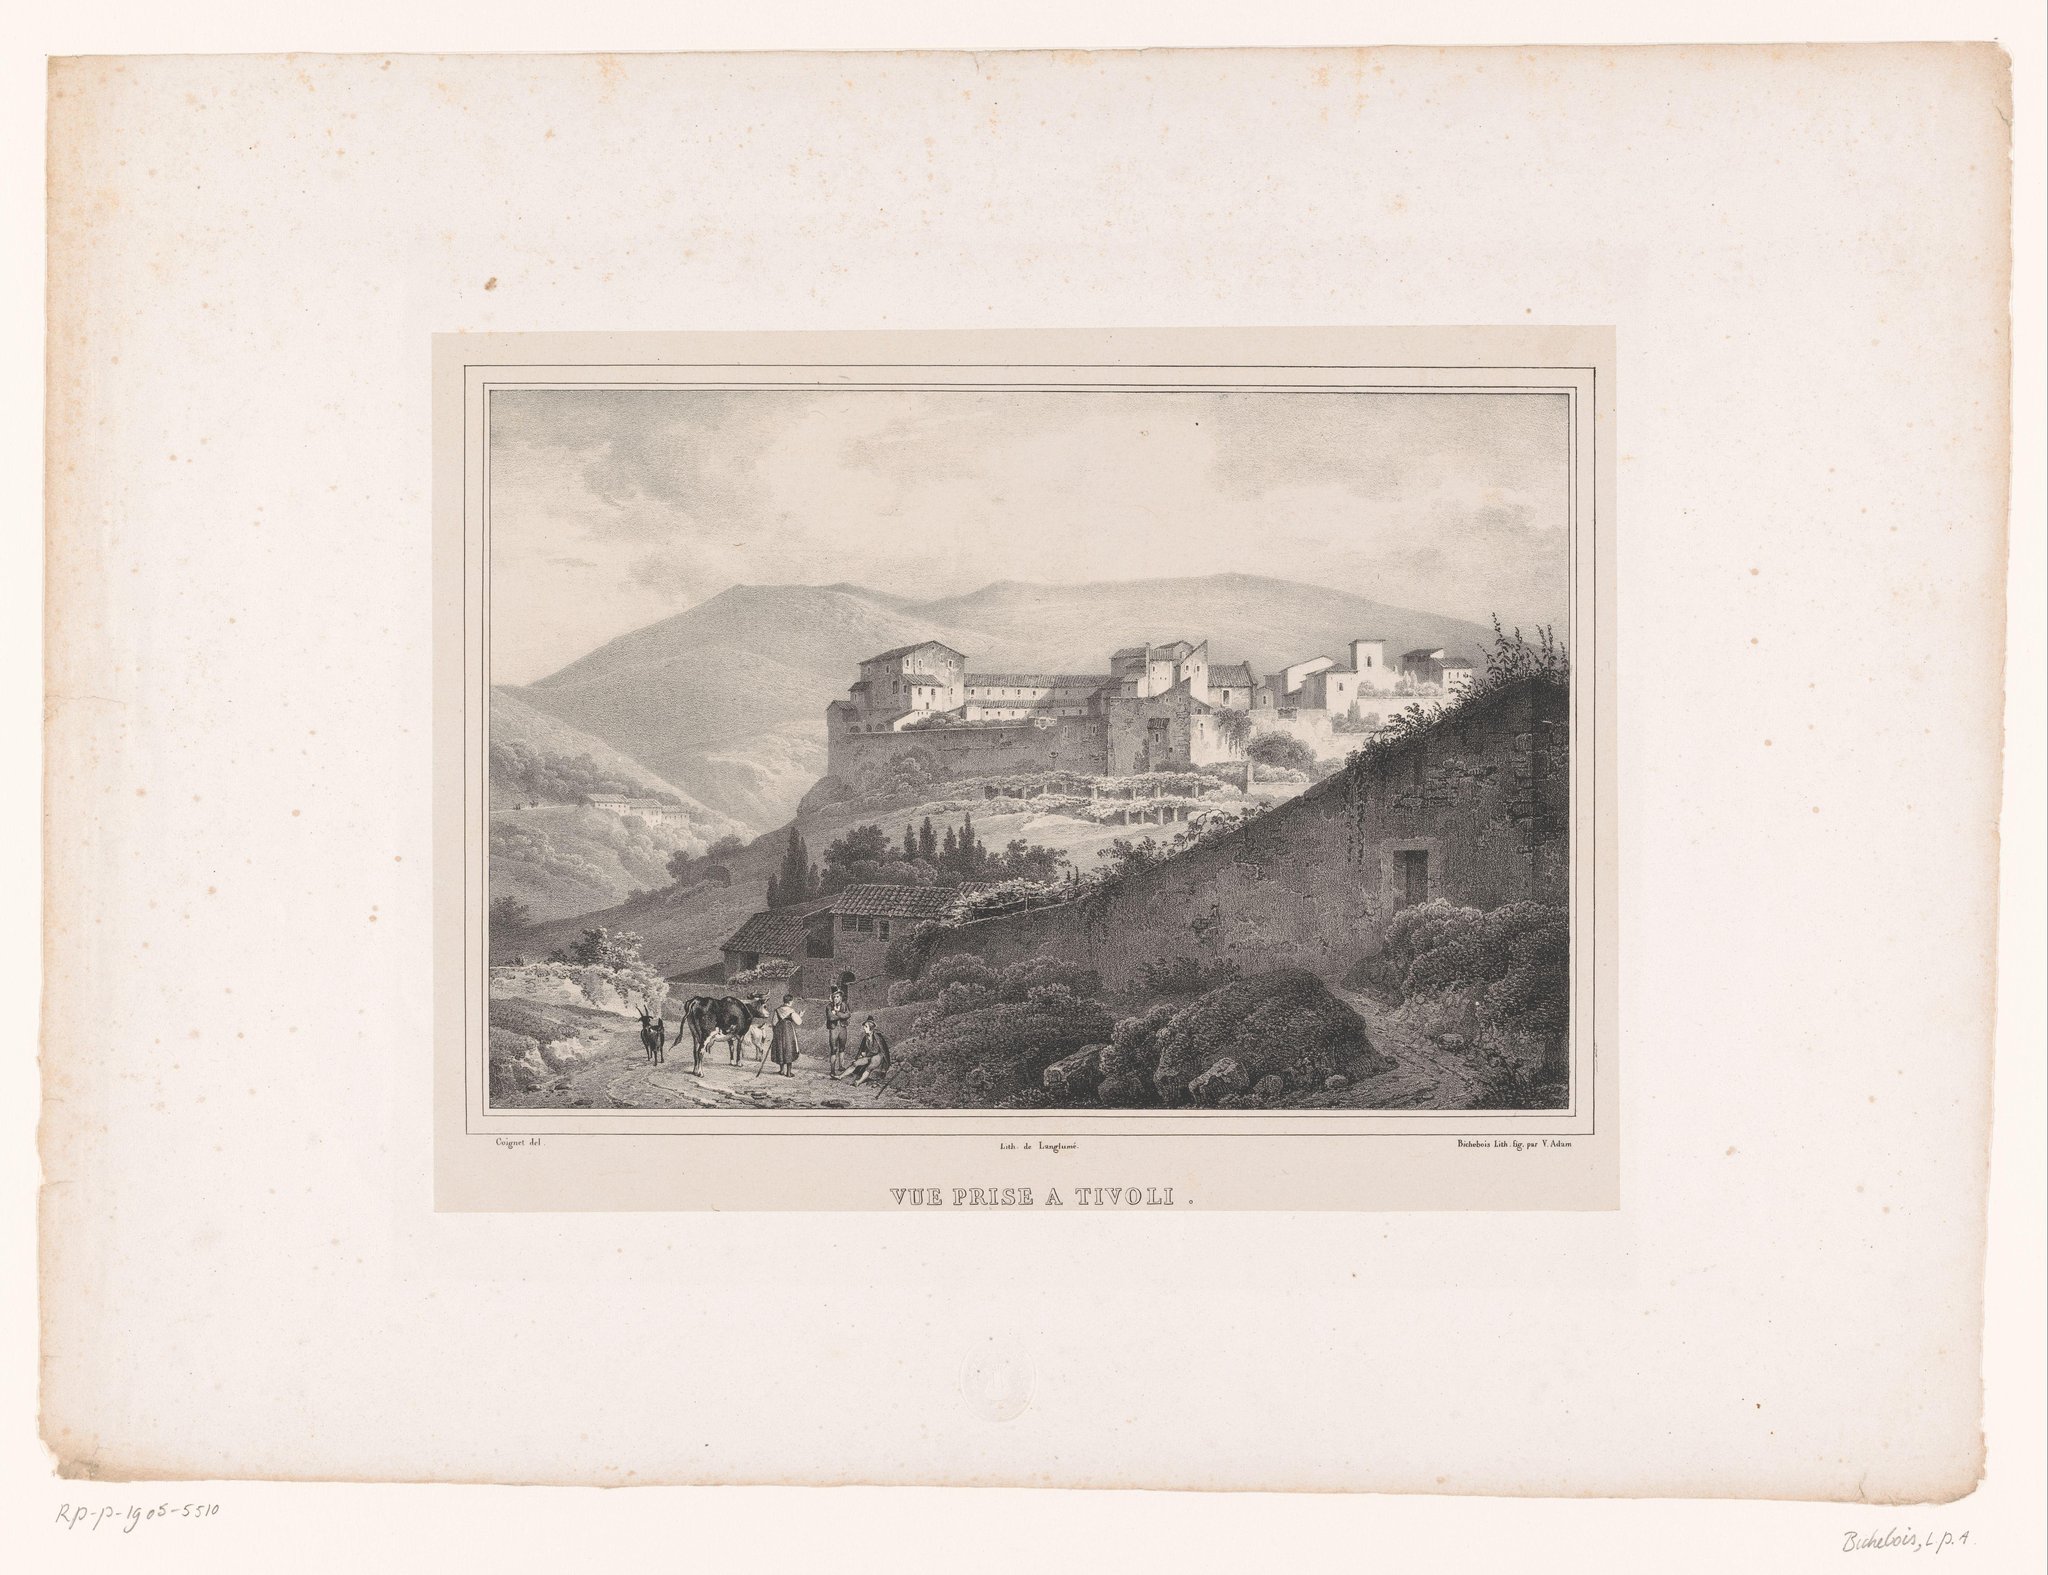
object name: print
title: Zicht op Tivoli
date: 1824-1826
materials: paper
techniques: lithograph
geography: paris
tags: low hill country (+ landscape with figures, staffage), prospect of village, silhouette of village (+ city(-scape) with figures, staffage), tivoli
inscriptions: check stamp: Lugt 3431, collector's mark: Lugt 2228